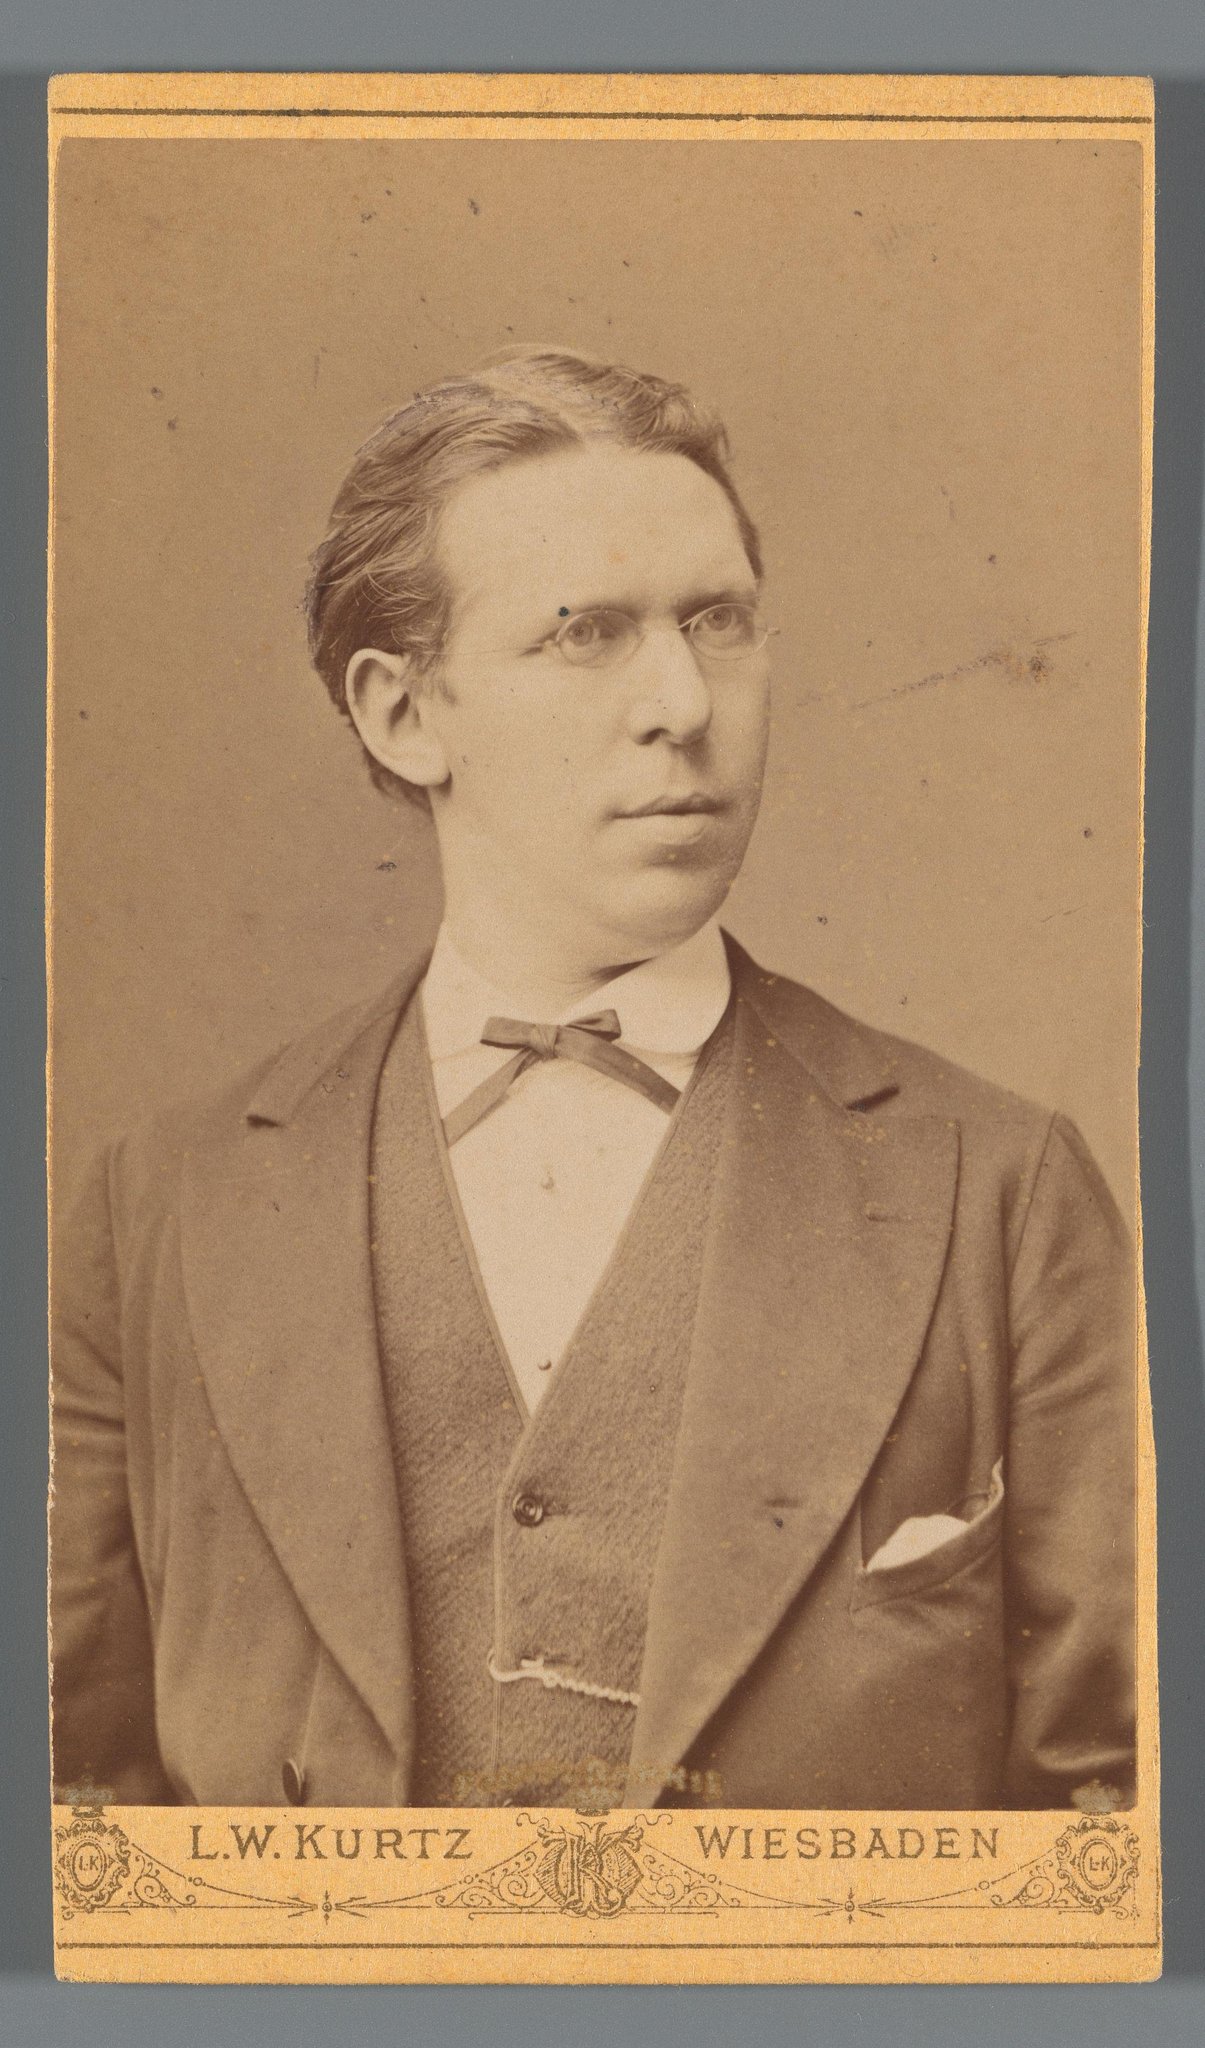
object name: photograph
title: Portret van Henricus Petrus Joannes van den Berg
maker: leonhard w. kurtz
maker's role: fotograaf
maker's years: 1849-1906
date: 1870-1900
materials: cardboard, photographic support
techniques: albumen print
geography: wiesbaden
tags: rotterdam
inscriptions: name: ‘H.P.J. vandenBerg’, name: ‘L.W. KURTZ / WIESBADEN’, name: ‘L.W.KURTZ WIESBADEN’